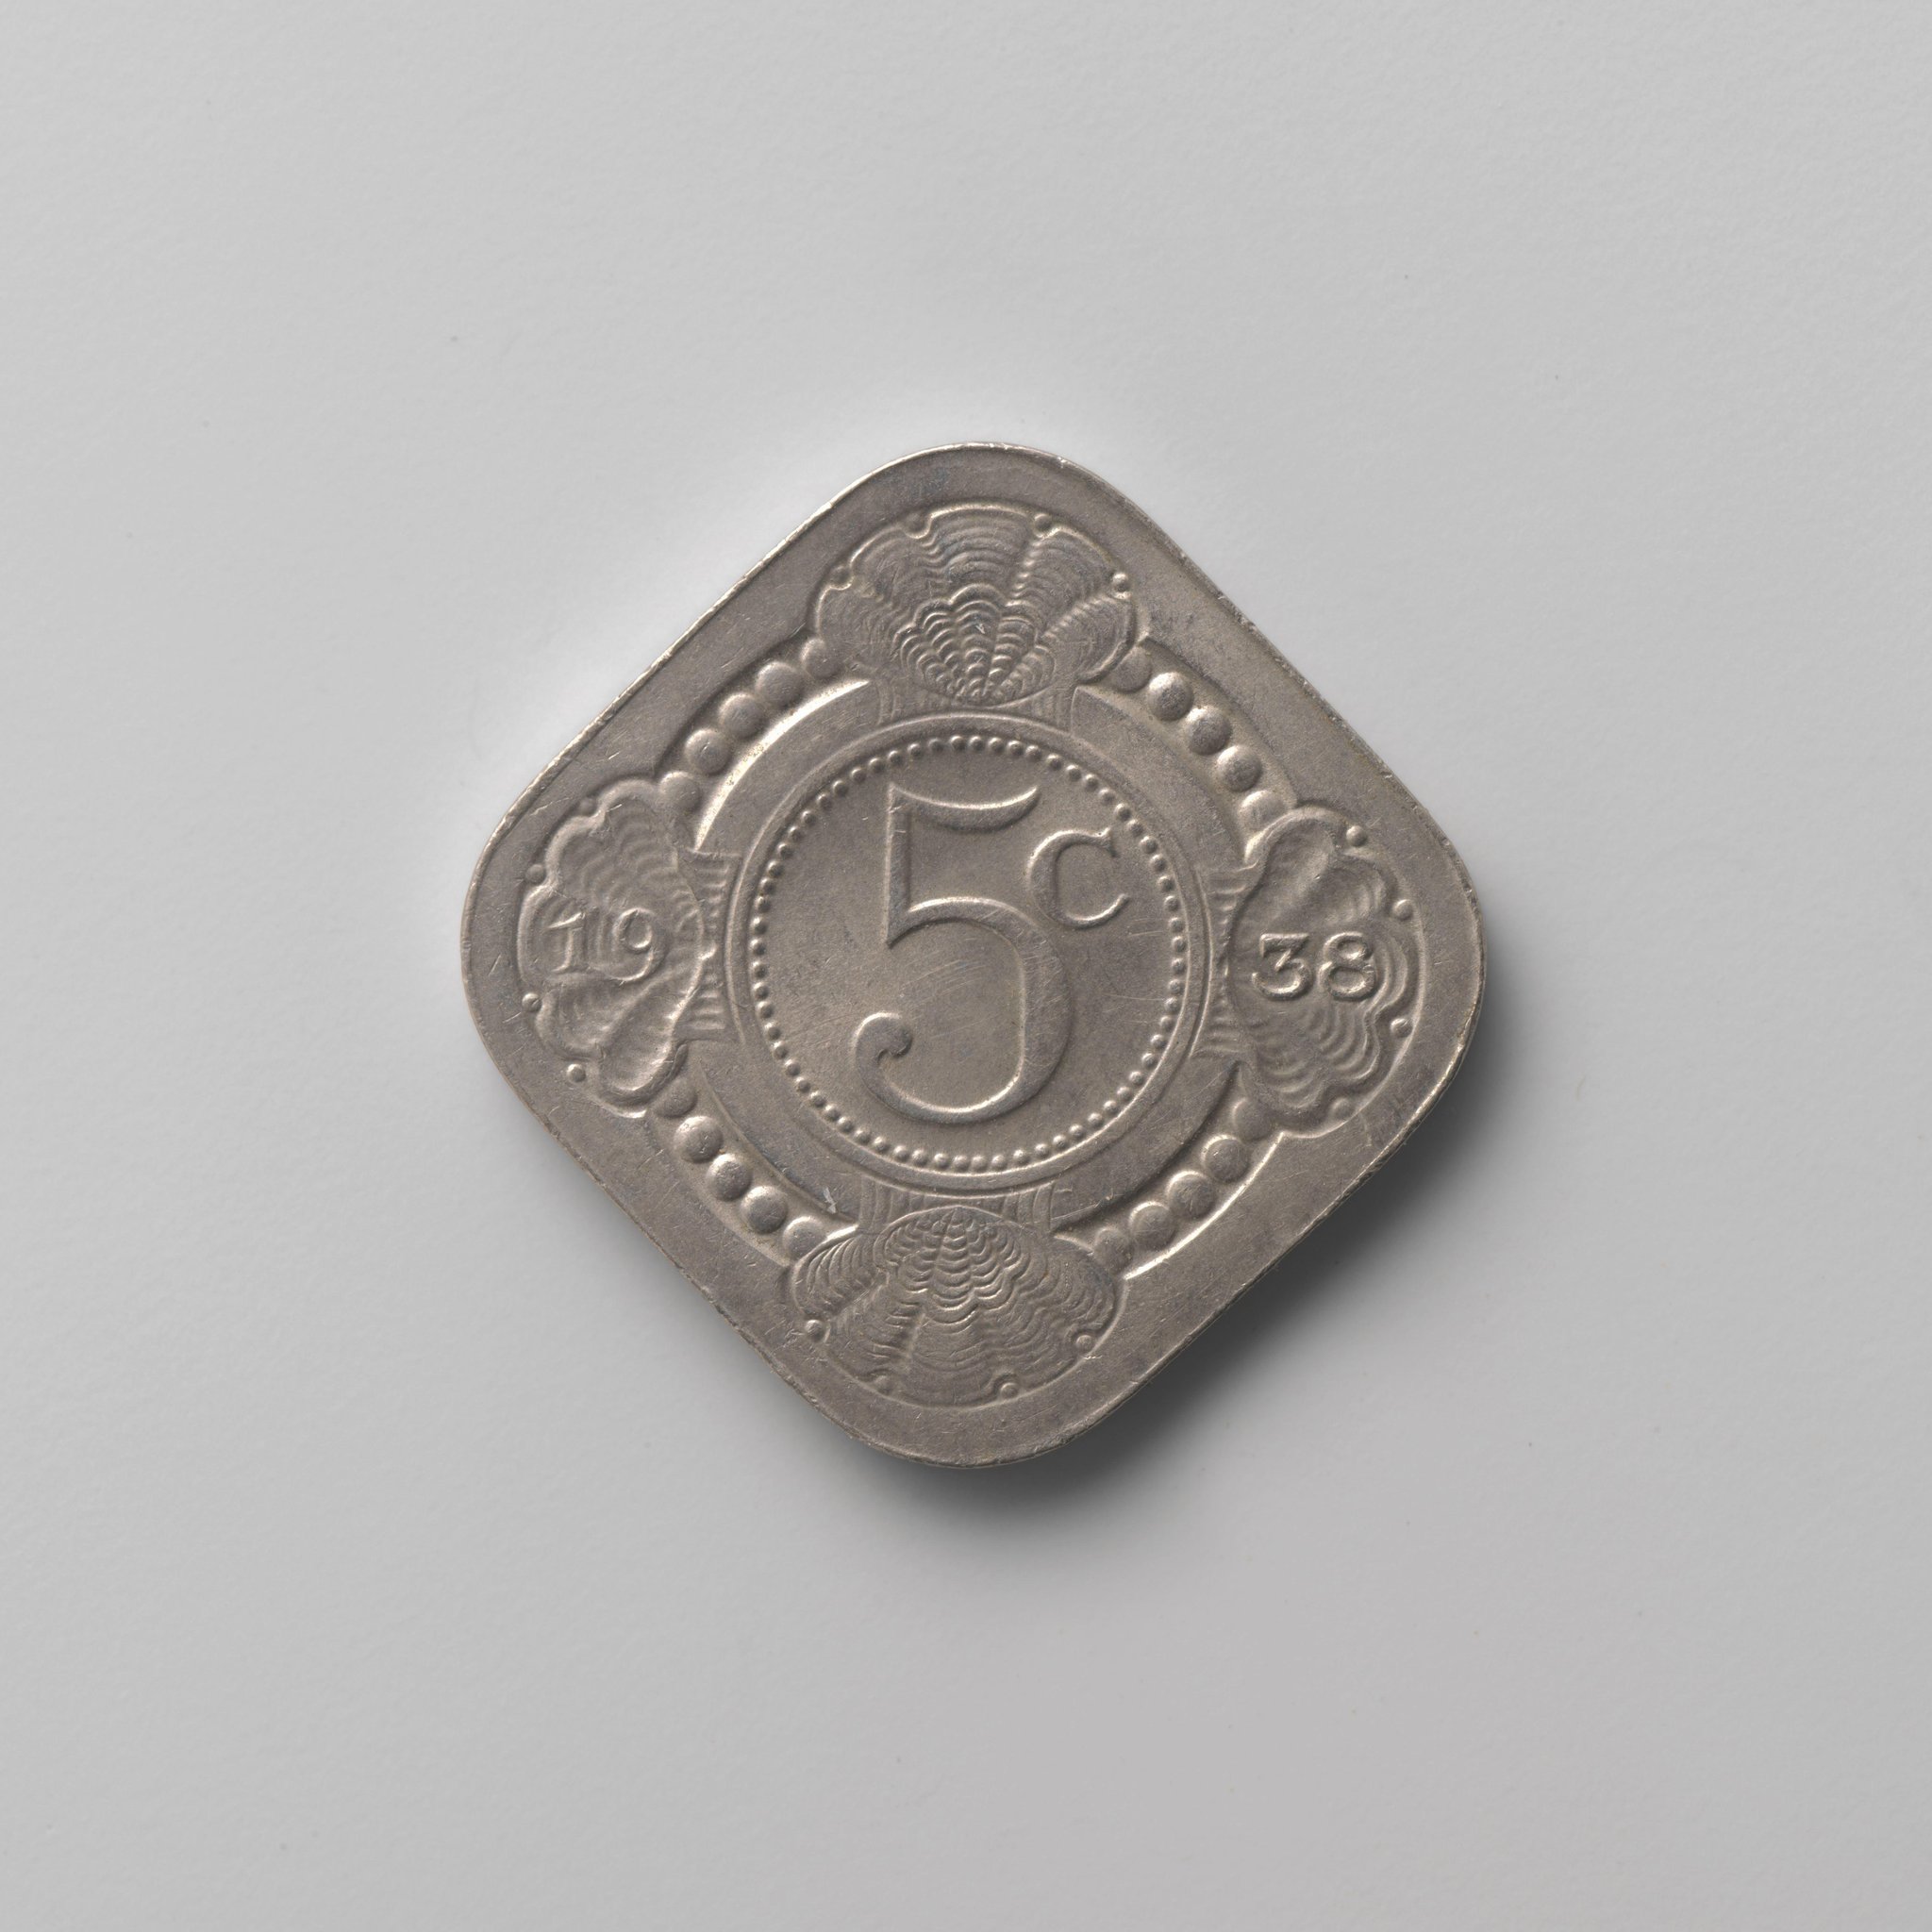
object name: coin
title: Nederlandse 5 cent,1938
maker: wilhelmina of the netherlands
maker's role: print maker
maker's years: 1880-1962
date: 1938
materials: nickel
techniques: striking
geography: utrecht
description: Vierkante nikkelen munt. Voorzijde: in hoeken versiering, daarbinnen twee cirkels, waarin landsaanduiding. Daarbinnen vruchtdragende tak van een oranje-appel. Keerzijde: in de vier hoeken schelpen-versiering, verbonden door parels. Daarbinnen waarde-aanduiding 5 C in parelrand. Jaartal in de twee schelpen links en rechts. Gladde rand.